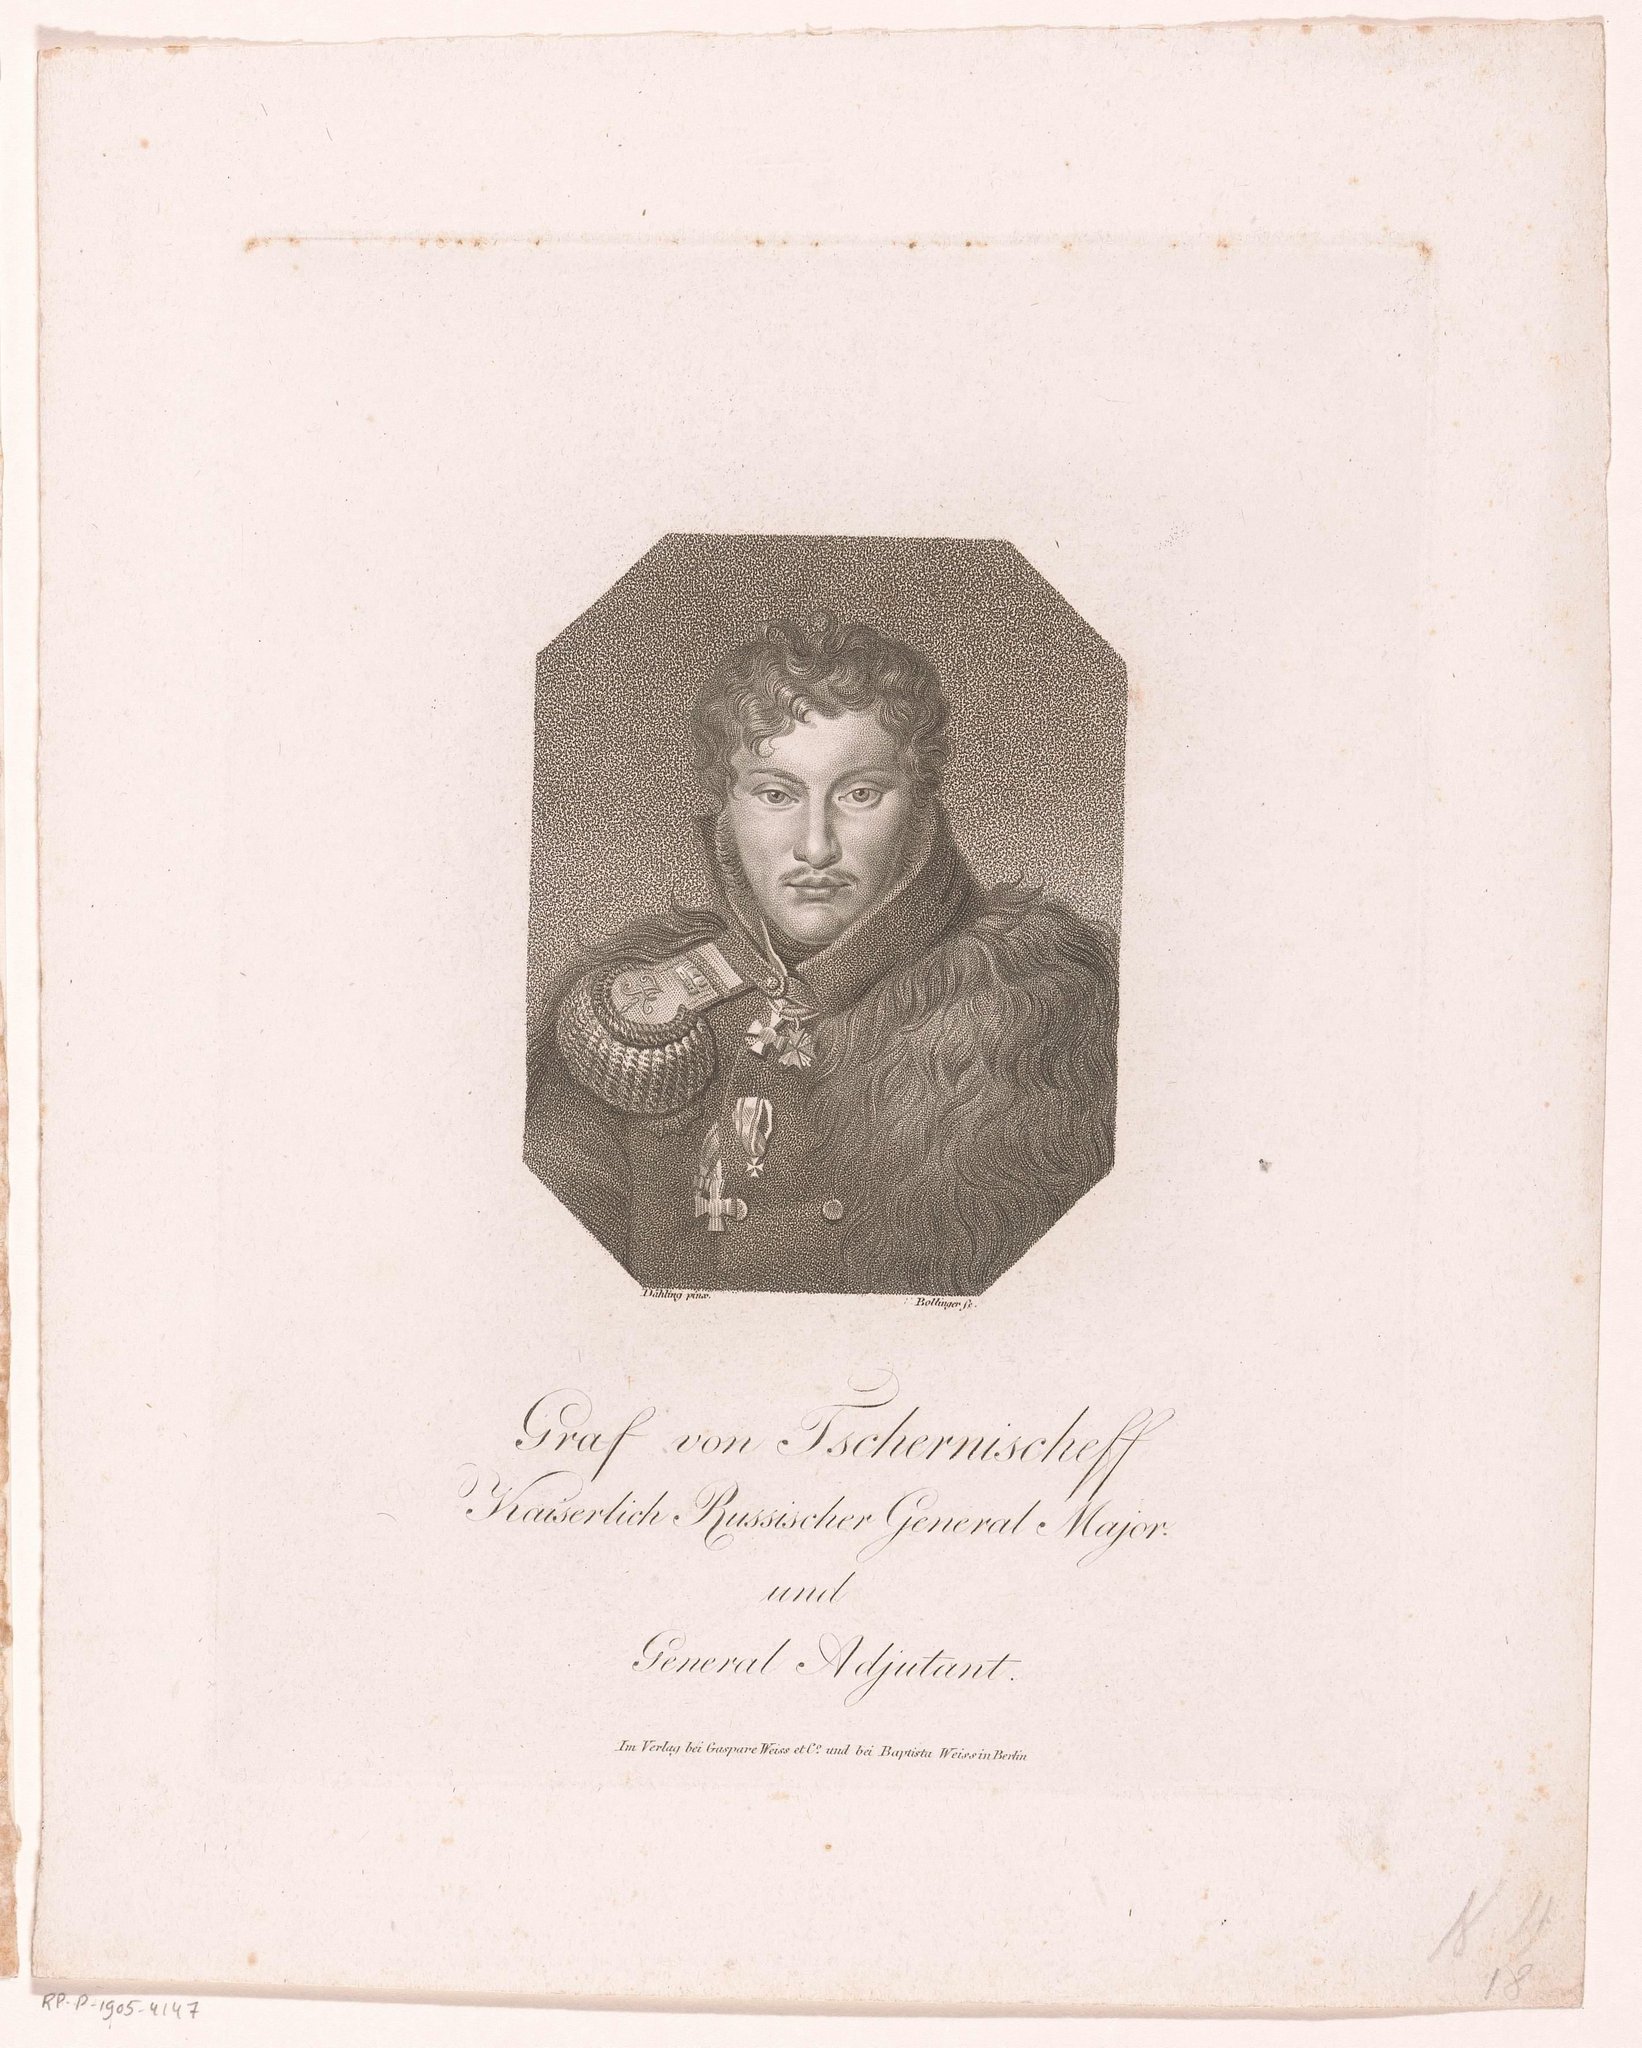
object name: print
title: Portret van Alexander Ivanovitsj Tsjernysjov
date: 1814-1825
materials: paper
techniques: stippling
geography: berlin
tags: knighthood order, historical persons, (military) uniforms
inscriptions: collector's mark: Lugt 2228